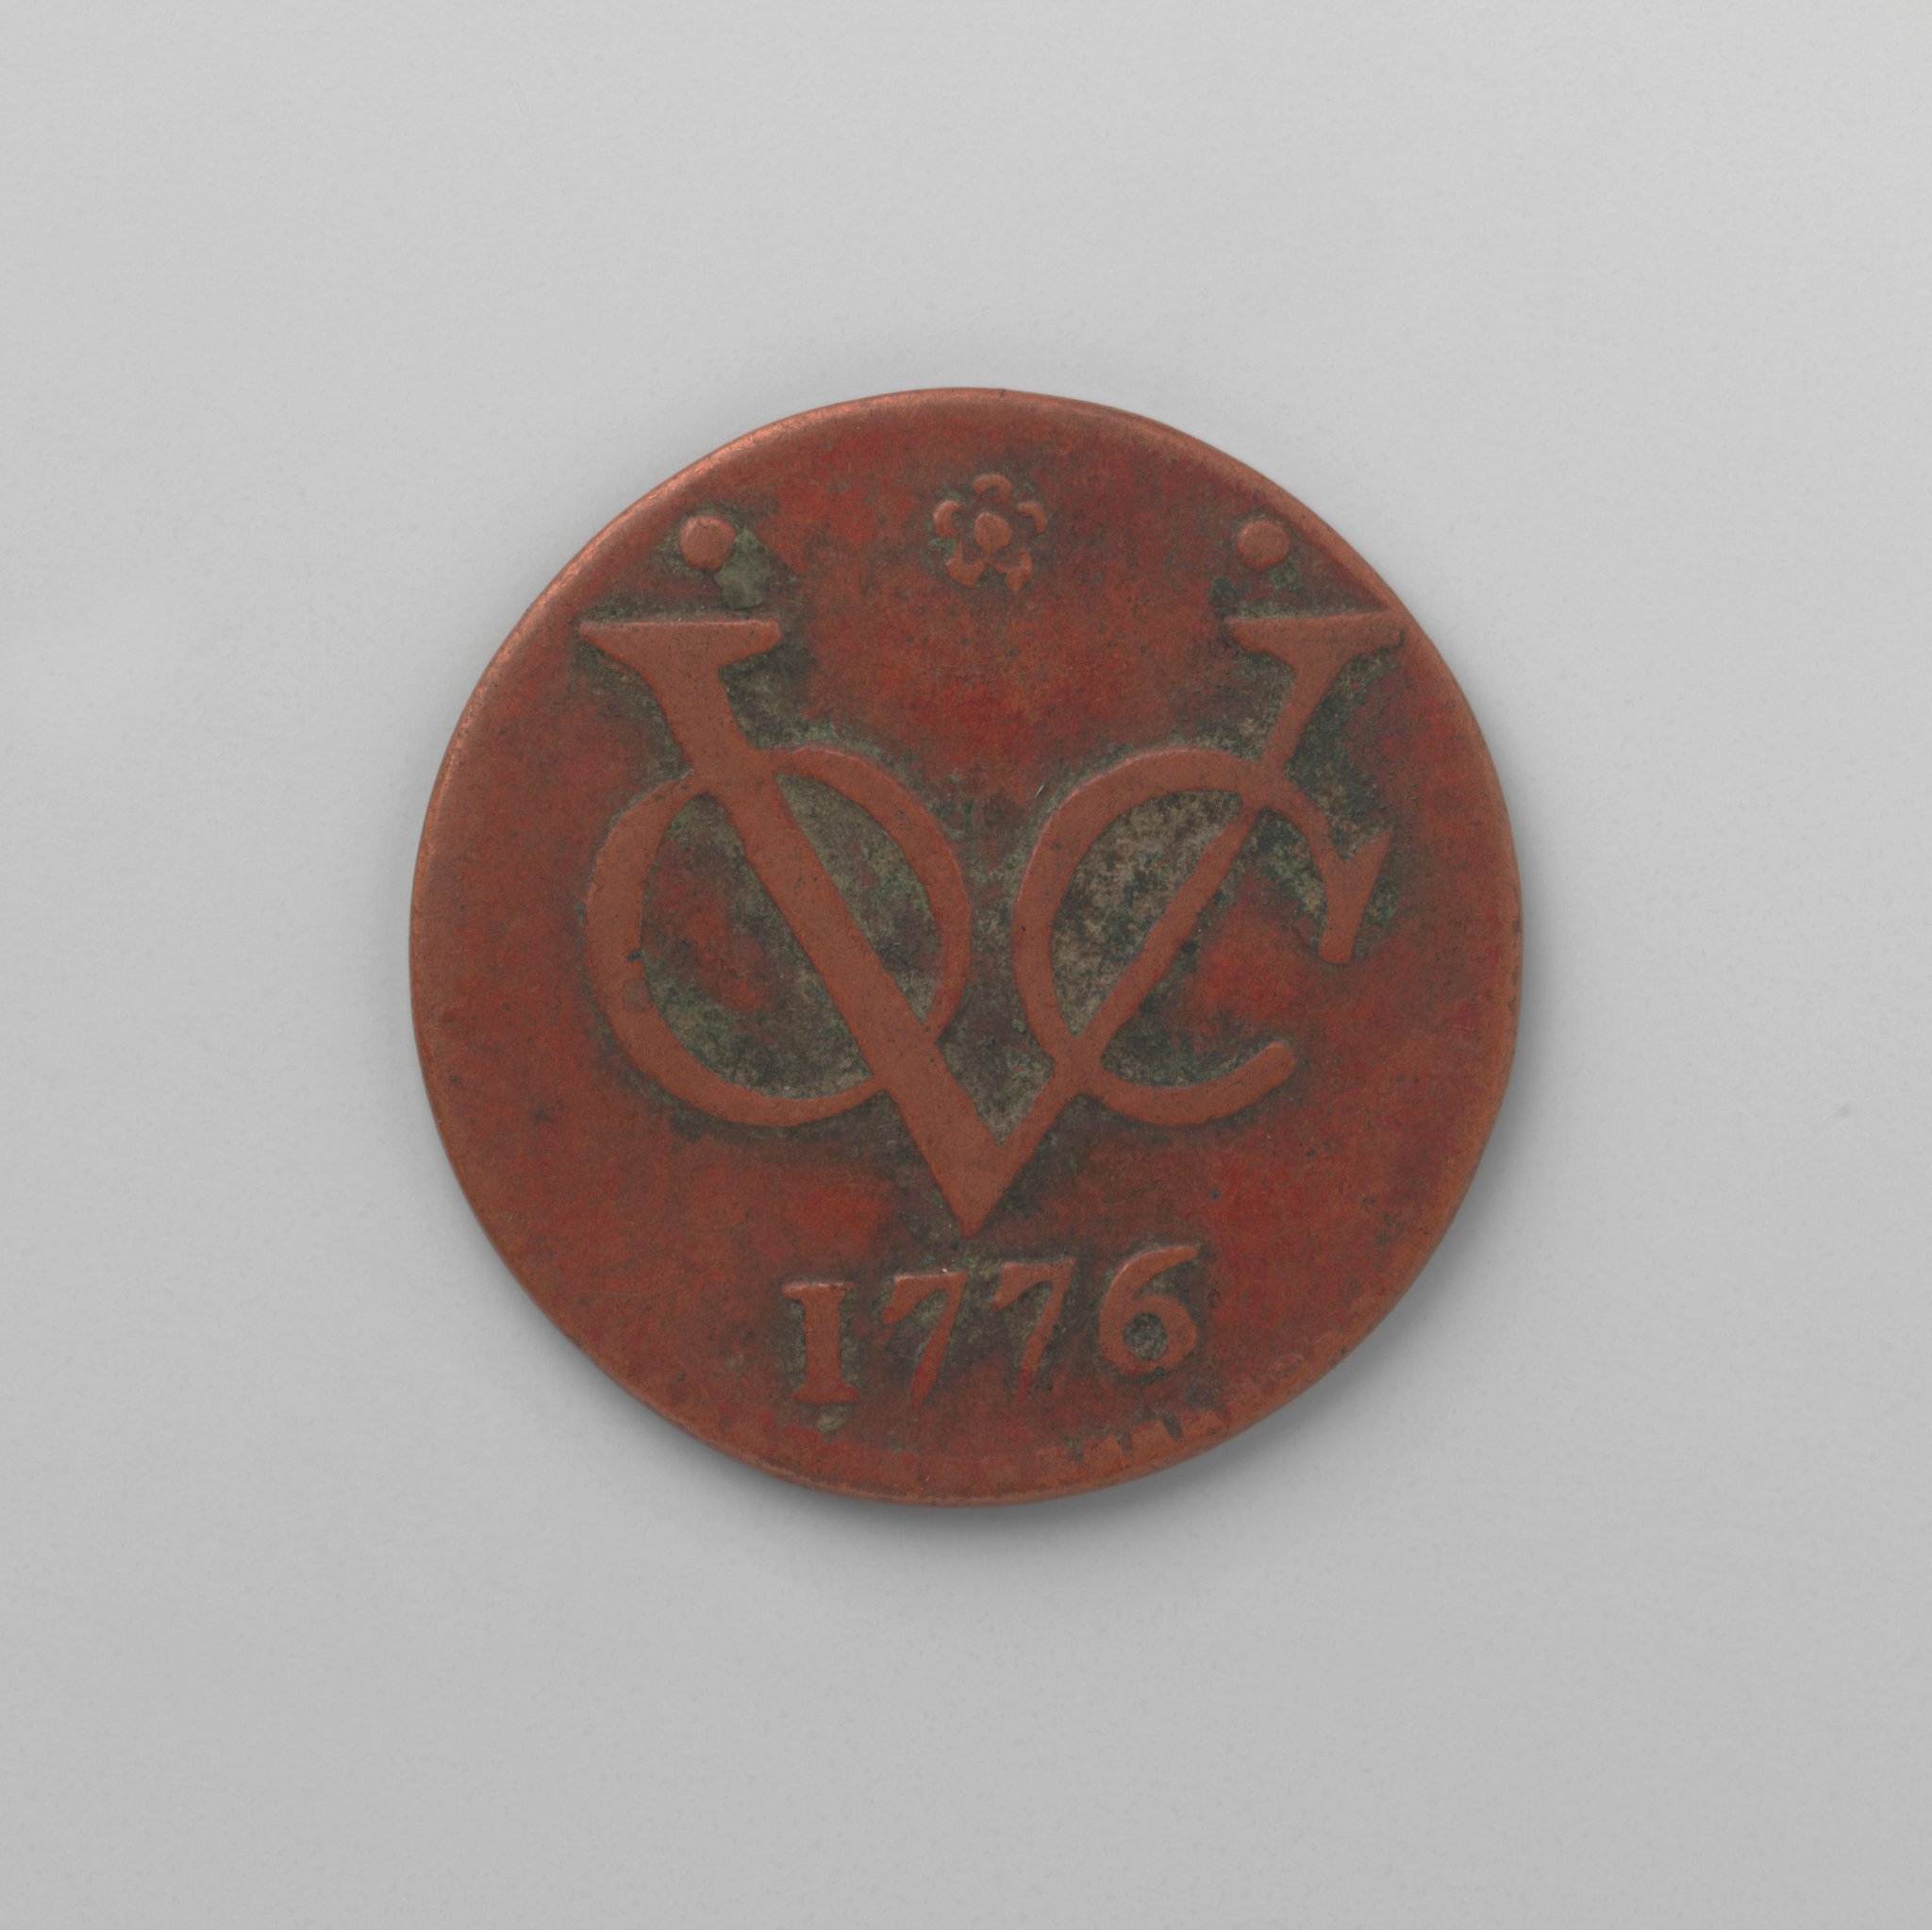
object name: coin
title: VOC, duit Westfriesland,1776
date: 1776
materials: copper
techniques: striking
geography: medemblik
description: Koperen munt. Voorzijde: gekroond wapenschild van Westfriesland. Keerzijde: monogram van de VOC, waarboven muntteken en waaronder jaartal. Gladde rand.